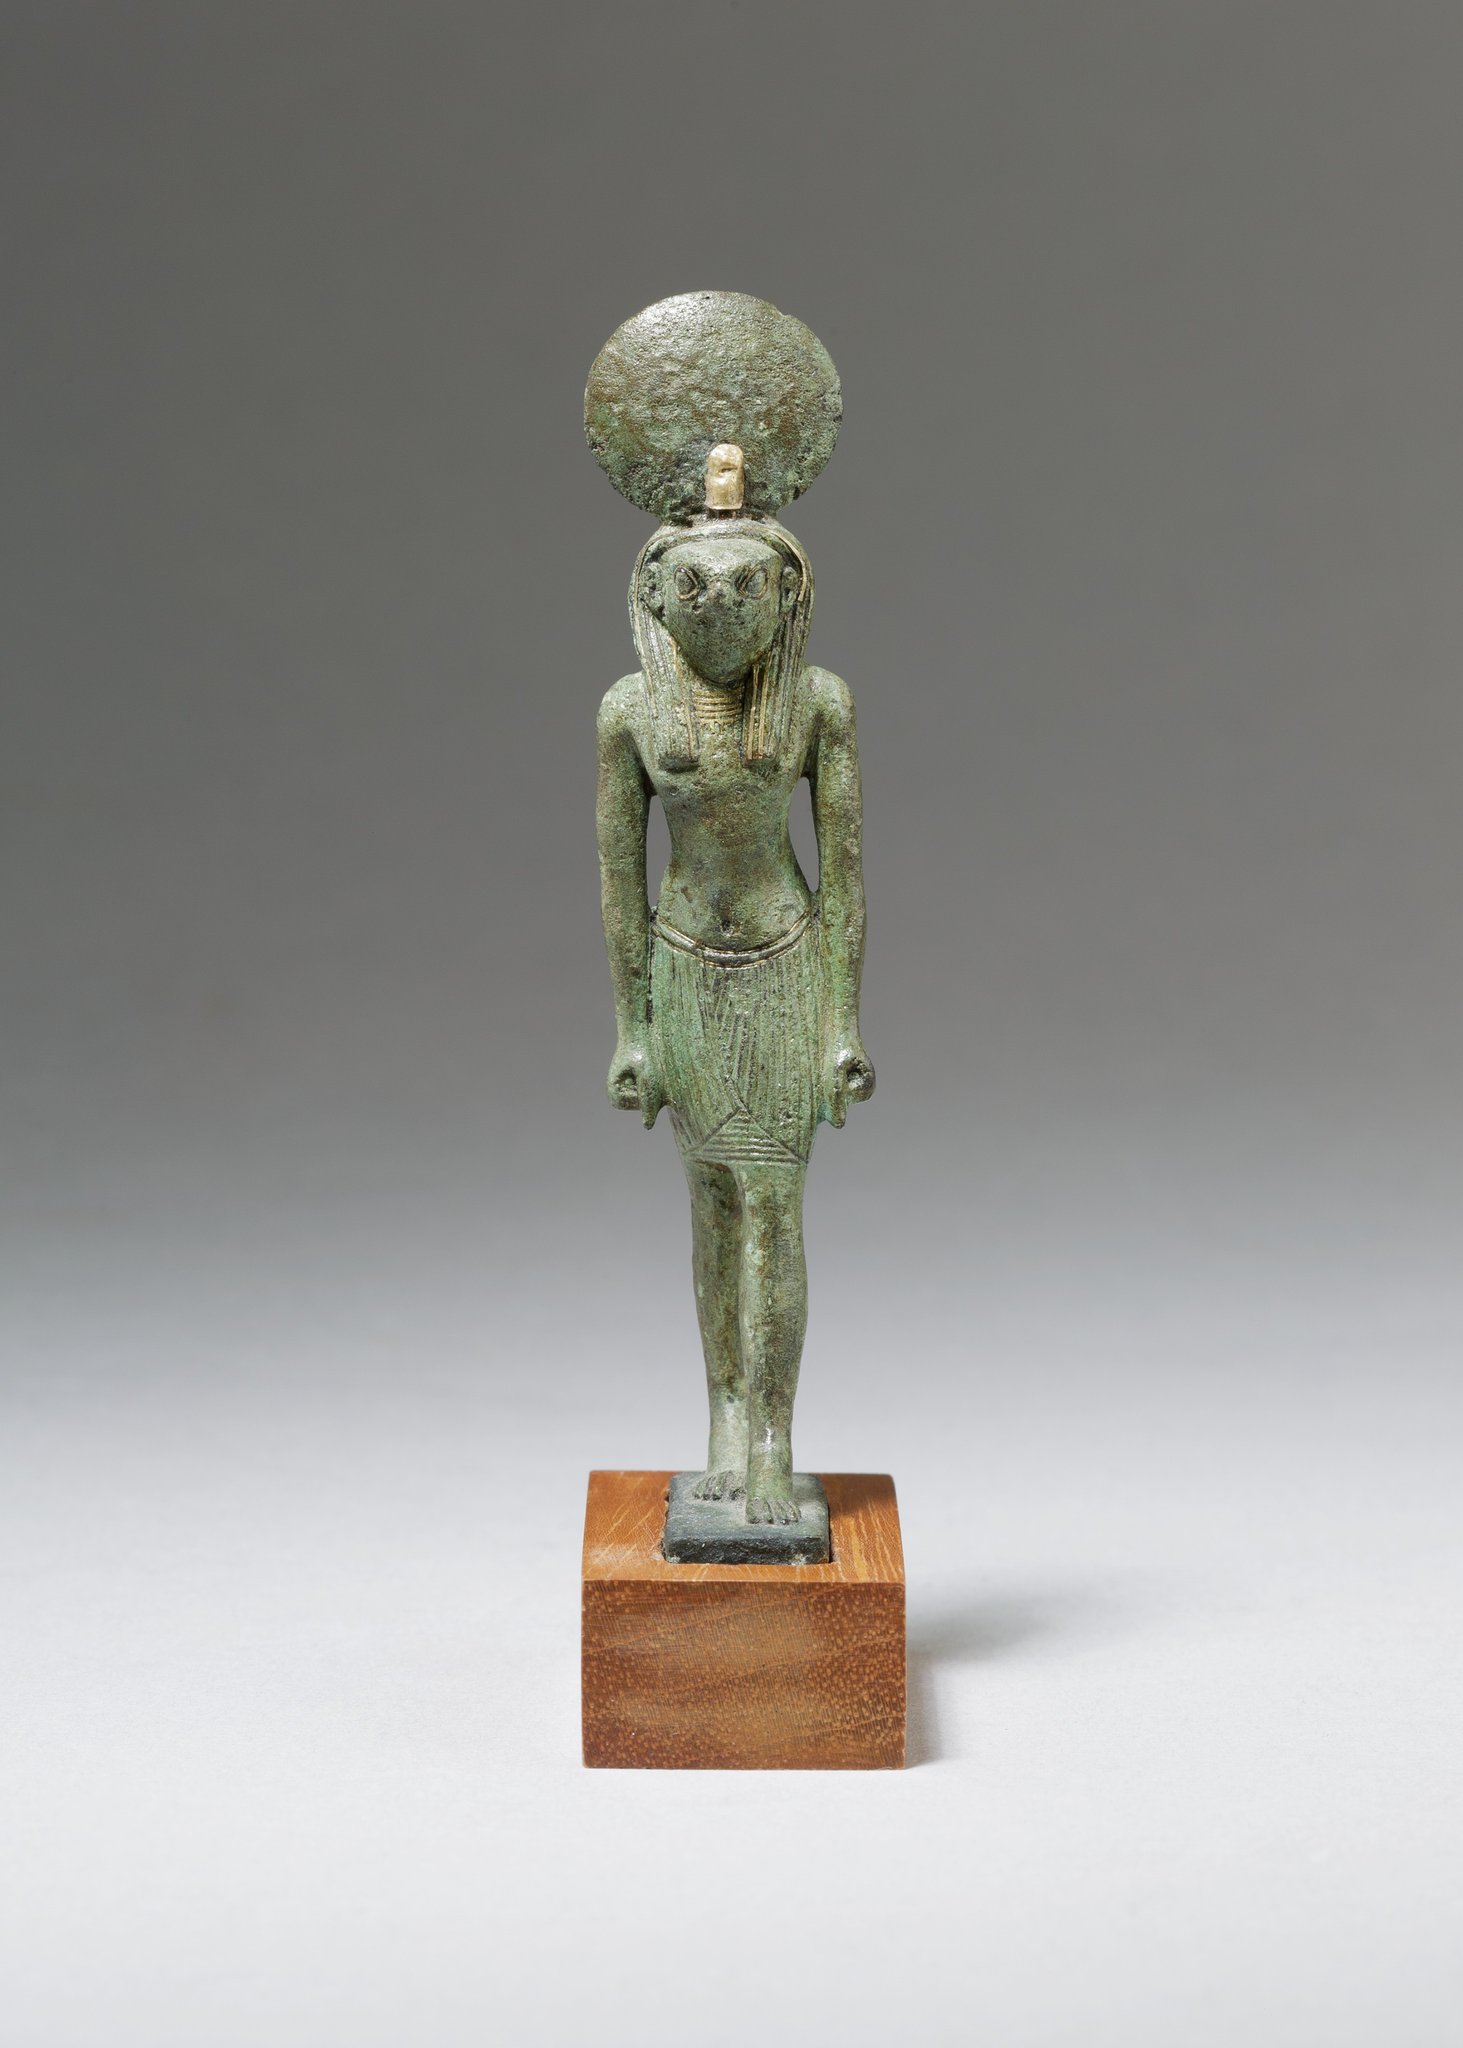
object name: amulet, falcon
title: Standing Figure of Re-Harakhty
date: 664-332 BCE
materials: metal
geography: egypt